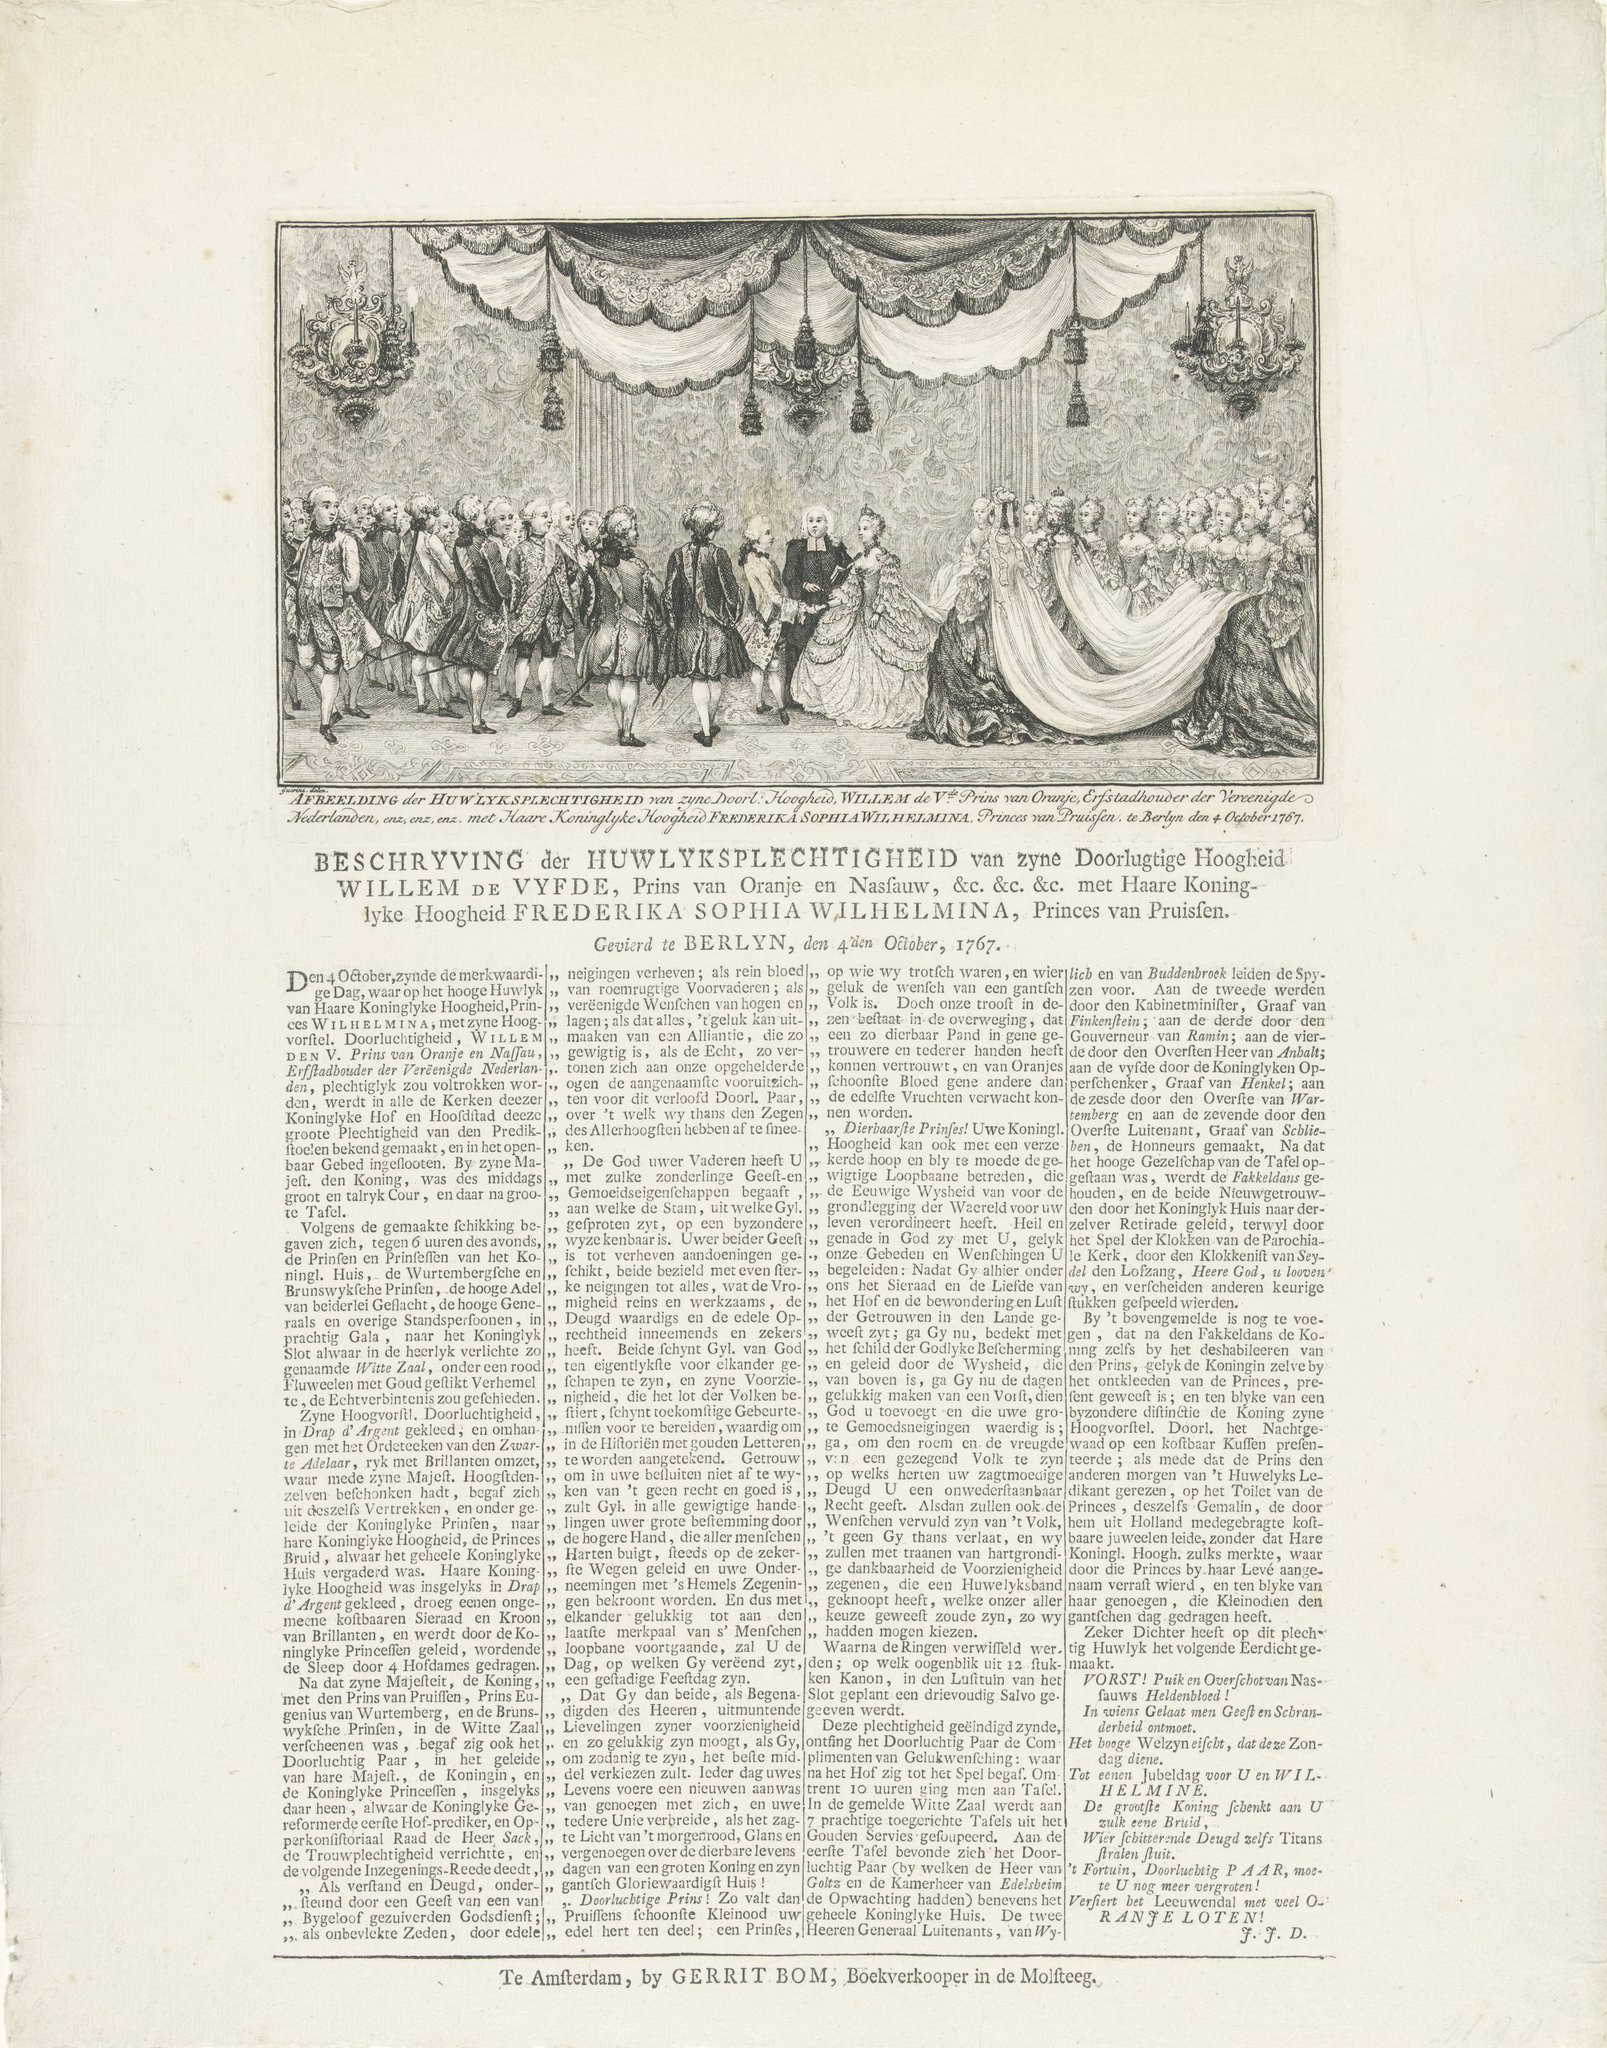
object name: print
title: Afbeelding der Huw'lyksplechtigheid van zyne Doorl. Hoogheid, Willem de V.de (...) met Haare Koninglyke Hoogheid Frederika Sophia Wilhelmina, Prinses van Pruisen. te Berlyn den 4 October 1767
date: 1767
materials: paper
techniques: engraving, etching, letterpress printing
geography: amsterdam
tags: the hague, william v (prince of orange), berlin, painter, draughtsman, wilhelmina of prussia (princess of orange), (civil) marriage ceremonies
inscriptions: collector's mark: Lugt 2228, collector's mark: Lugt 2166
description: Huwelijk van stadhouder Willem V en prinses Wilhelmina van Pruisen te Berlijn op 4 oktober 1767. Voorstelling van de huwelijksceremonie met op het blad onder de plaat een beschrijving van de gebeurtenissen in vier kolommen.